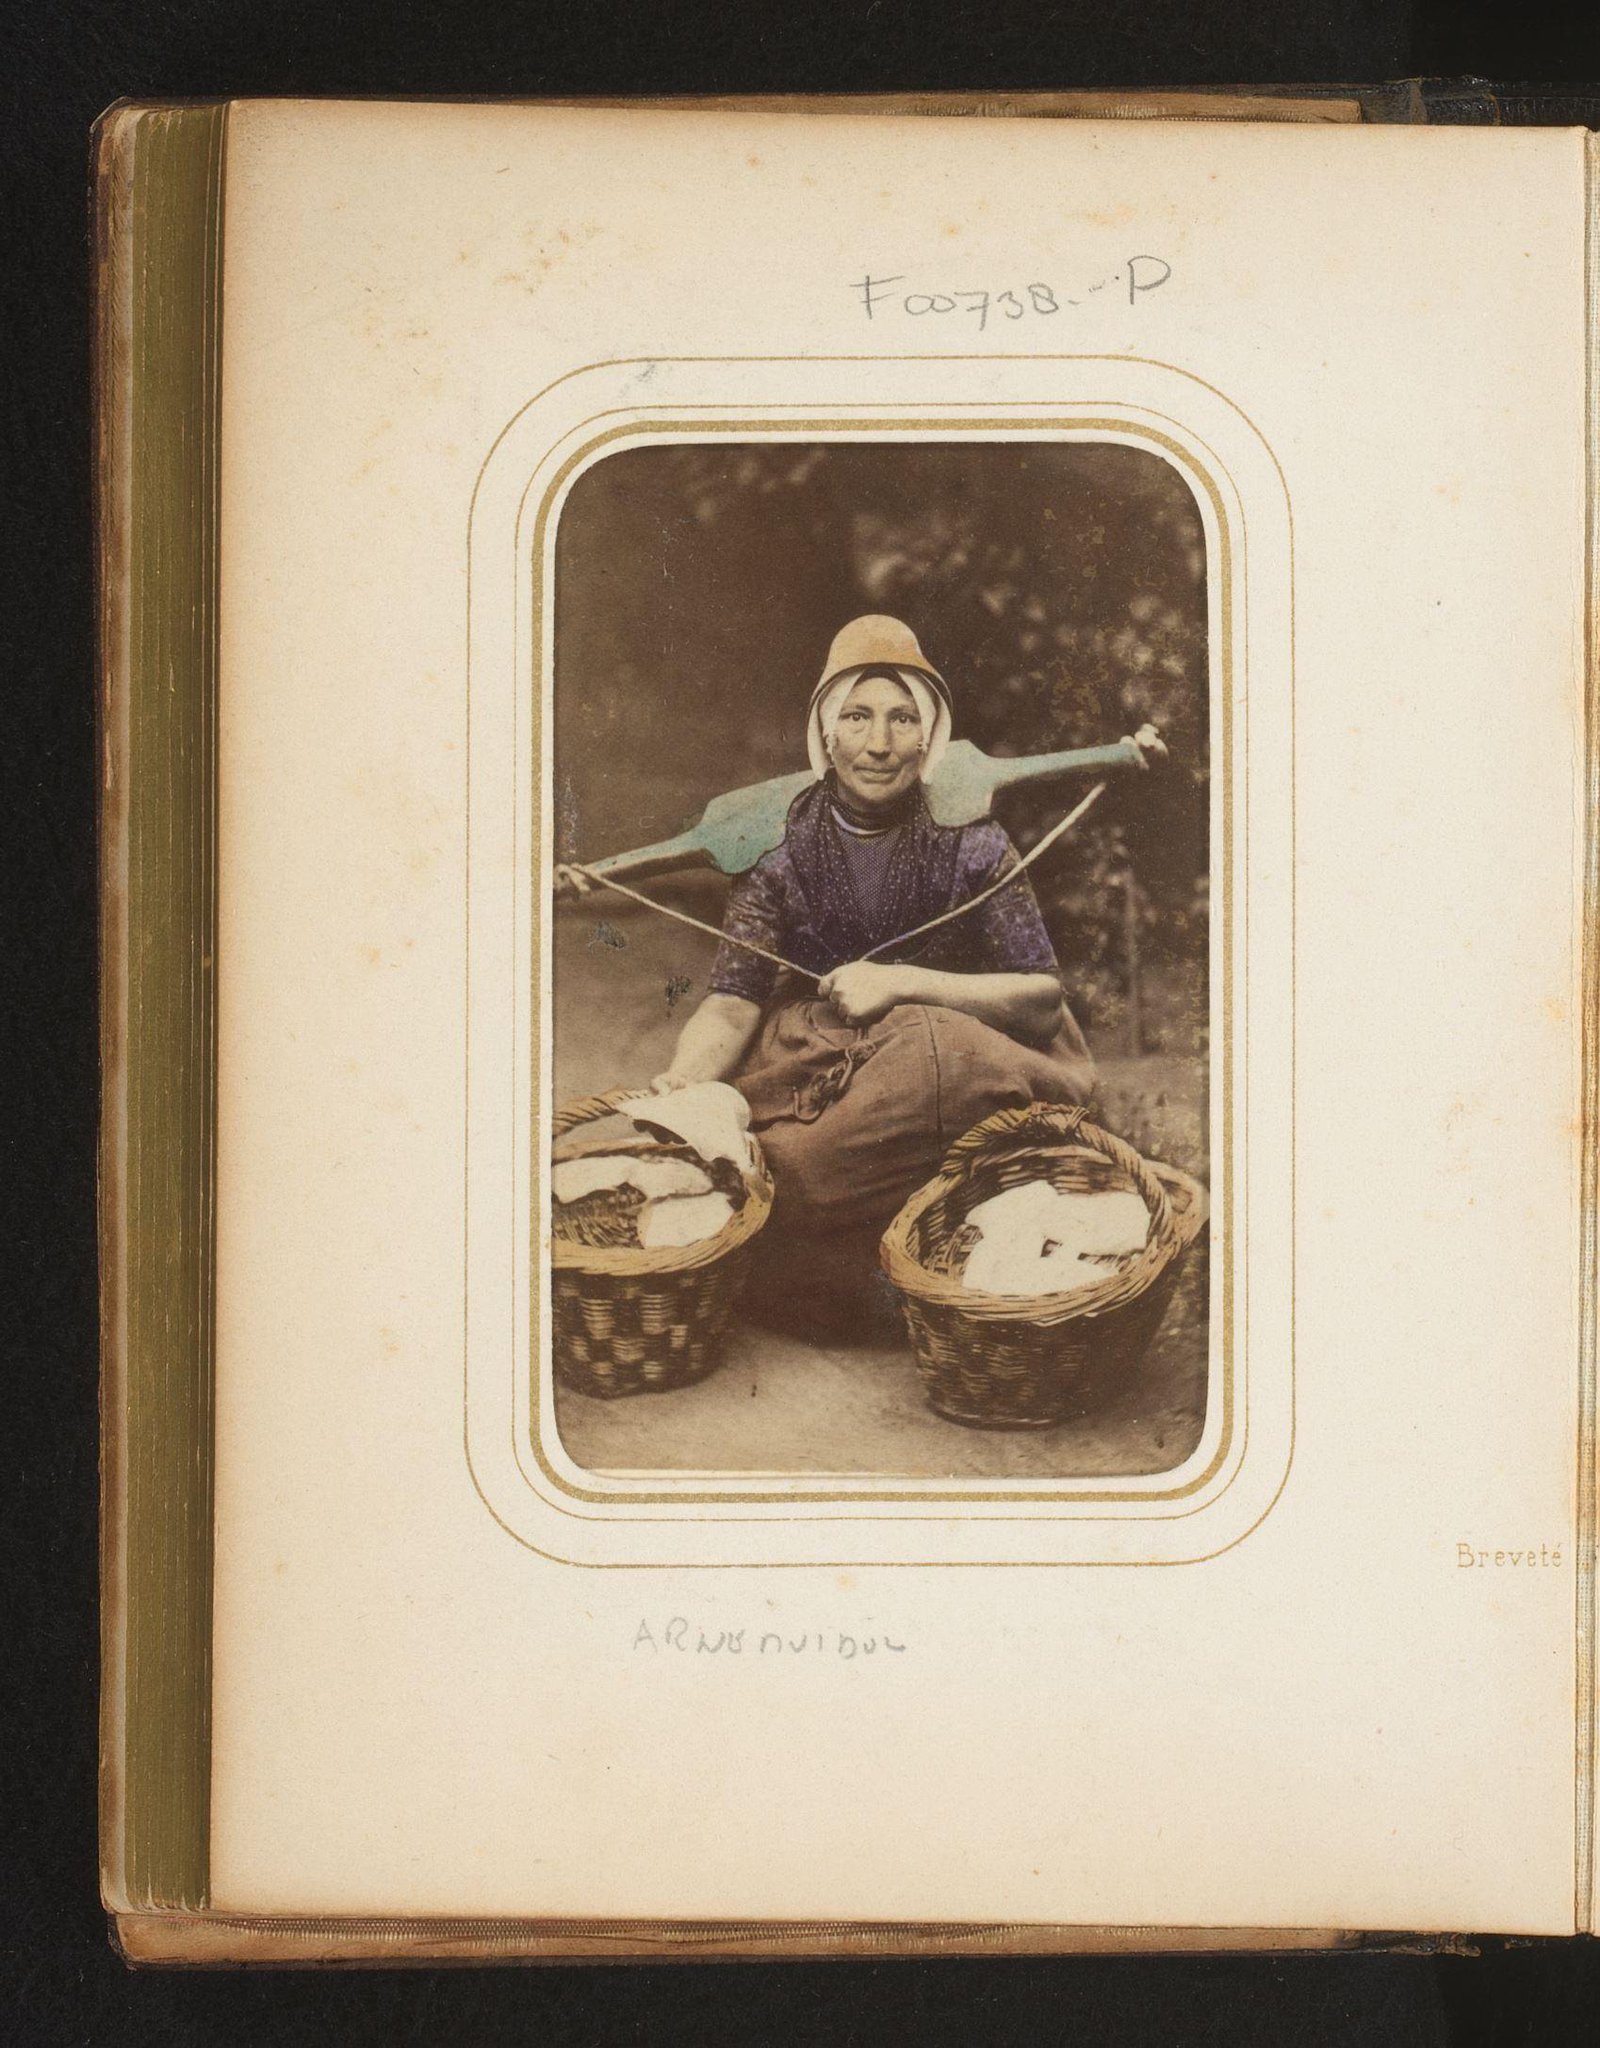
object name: carte de visite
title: Portret van een vrouw met juk en manden met vermoedelijk mutsjes, in klederdracht van Arnemuiden, Zeeland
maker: andries jager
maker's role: publisher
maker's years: 1825-1905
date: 1860-1890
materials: cardboard, photographic support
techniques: albumen print, hand coloring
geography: amsterdam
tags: folk costume, regional costume (+ women's clothes), historical persons - bb - woman, carrying something with yoke, netherlands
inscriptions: inscription: ‘Publiés par A. Jager, Water 110 Amsterdam./ Le droit de reproduction réservé.’, inscription: ‘Breveté S.G.D.G.’, annotation: ‘Arnemuiden’